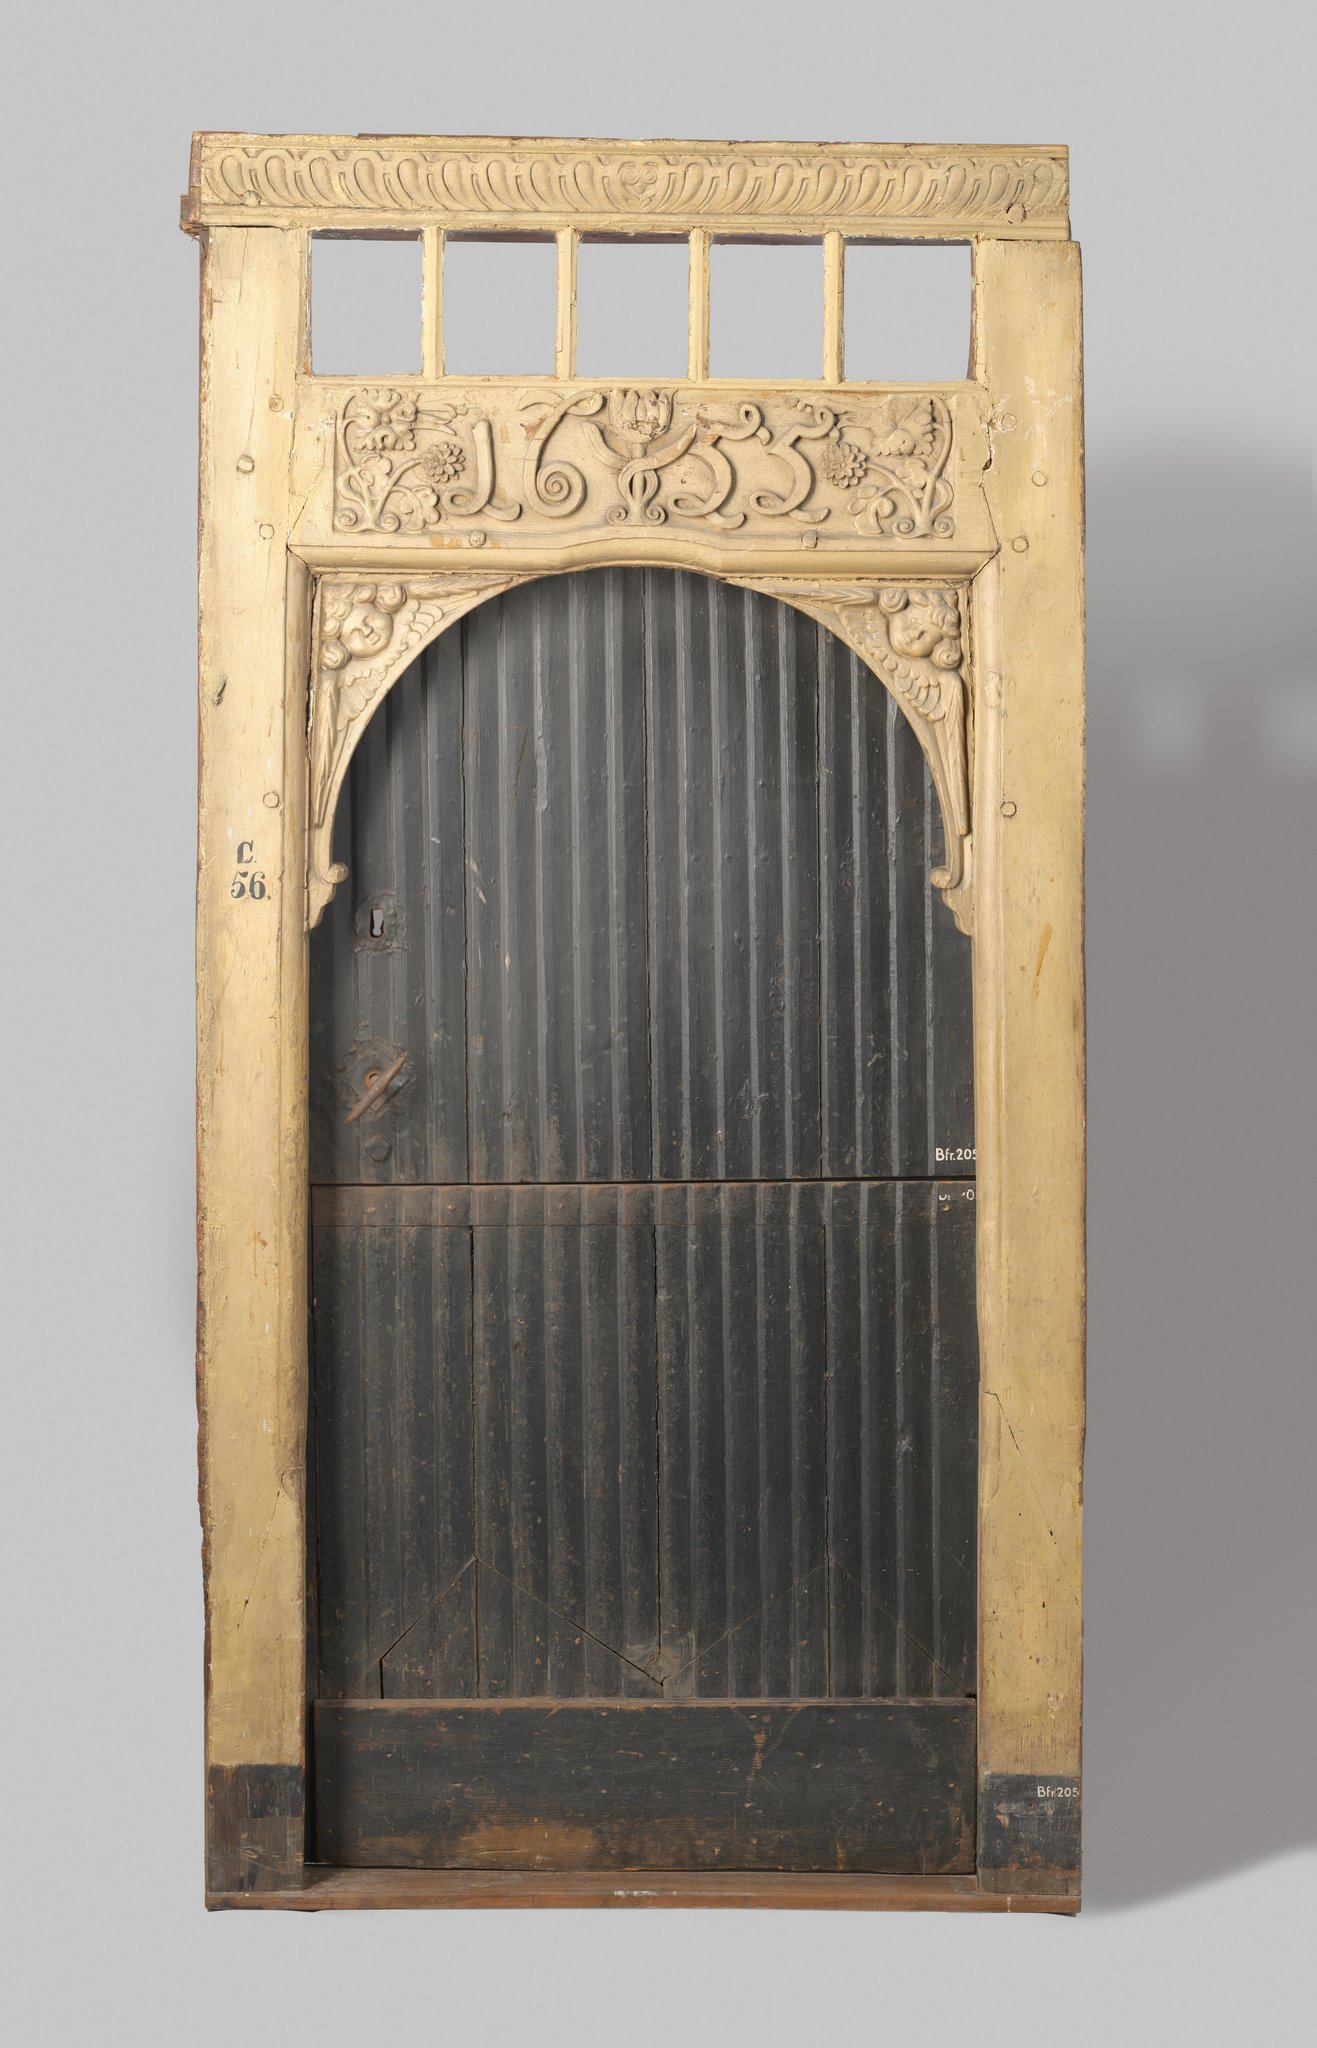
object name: doorframe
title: Deurkozijn, met deur en bovenlicht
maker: Anonymous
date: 1655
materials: wood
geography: netherlands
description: Volledig deurkozijn van eikenhout met bovenlicht en deur. De deur is horizontaal in tweeën gedeeld. Op de bovendorpel (het kalf) staat het jaartal 1655 tussen lofwerk. Afkomstig van Oudekerk a/d IJsel.